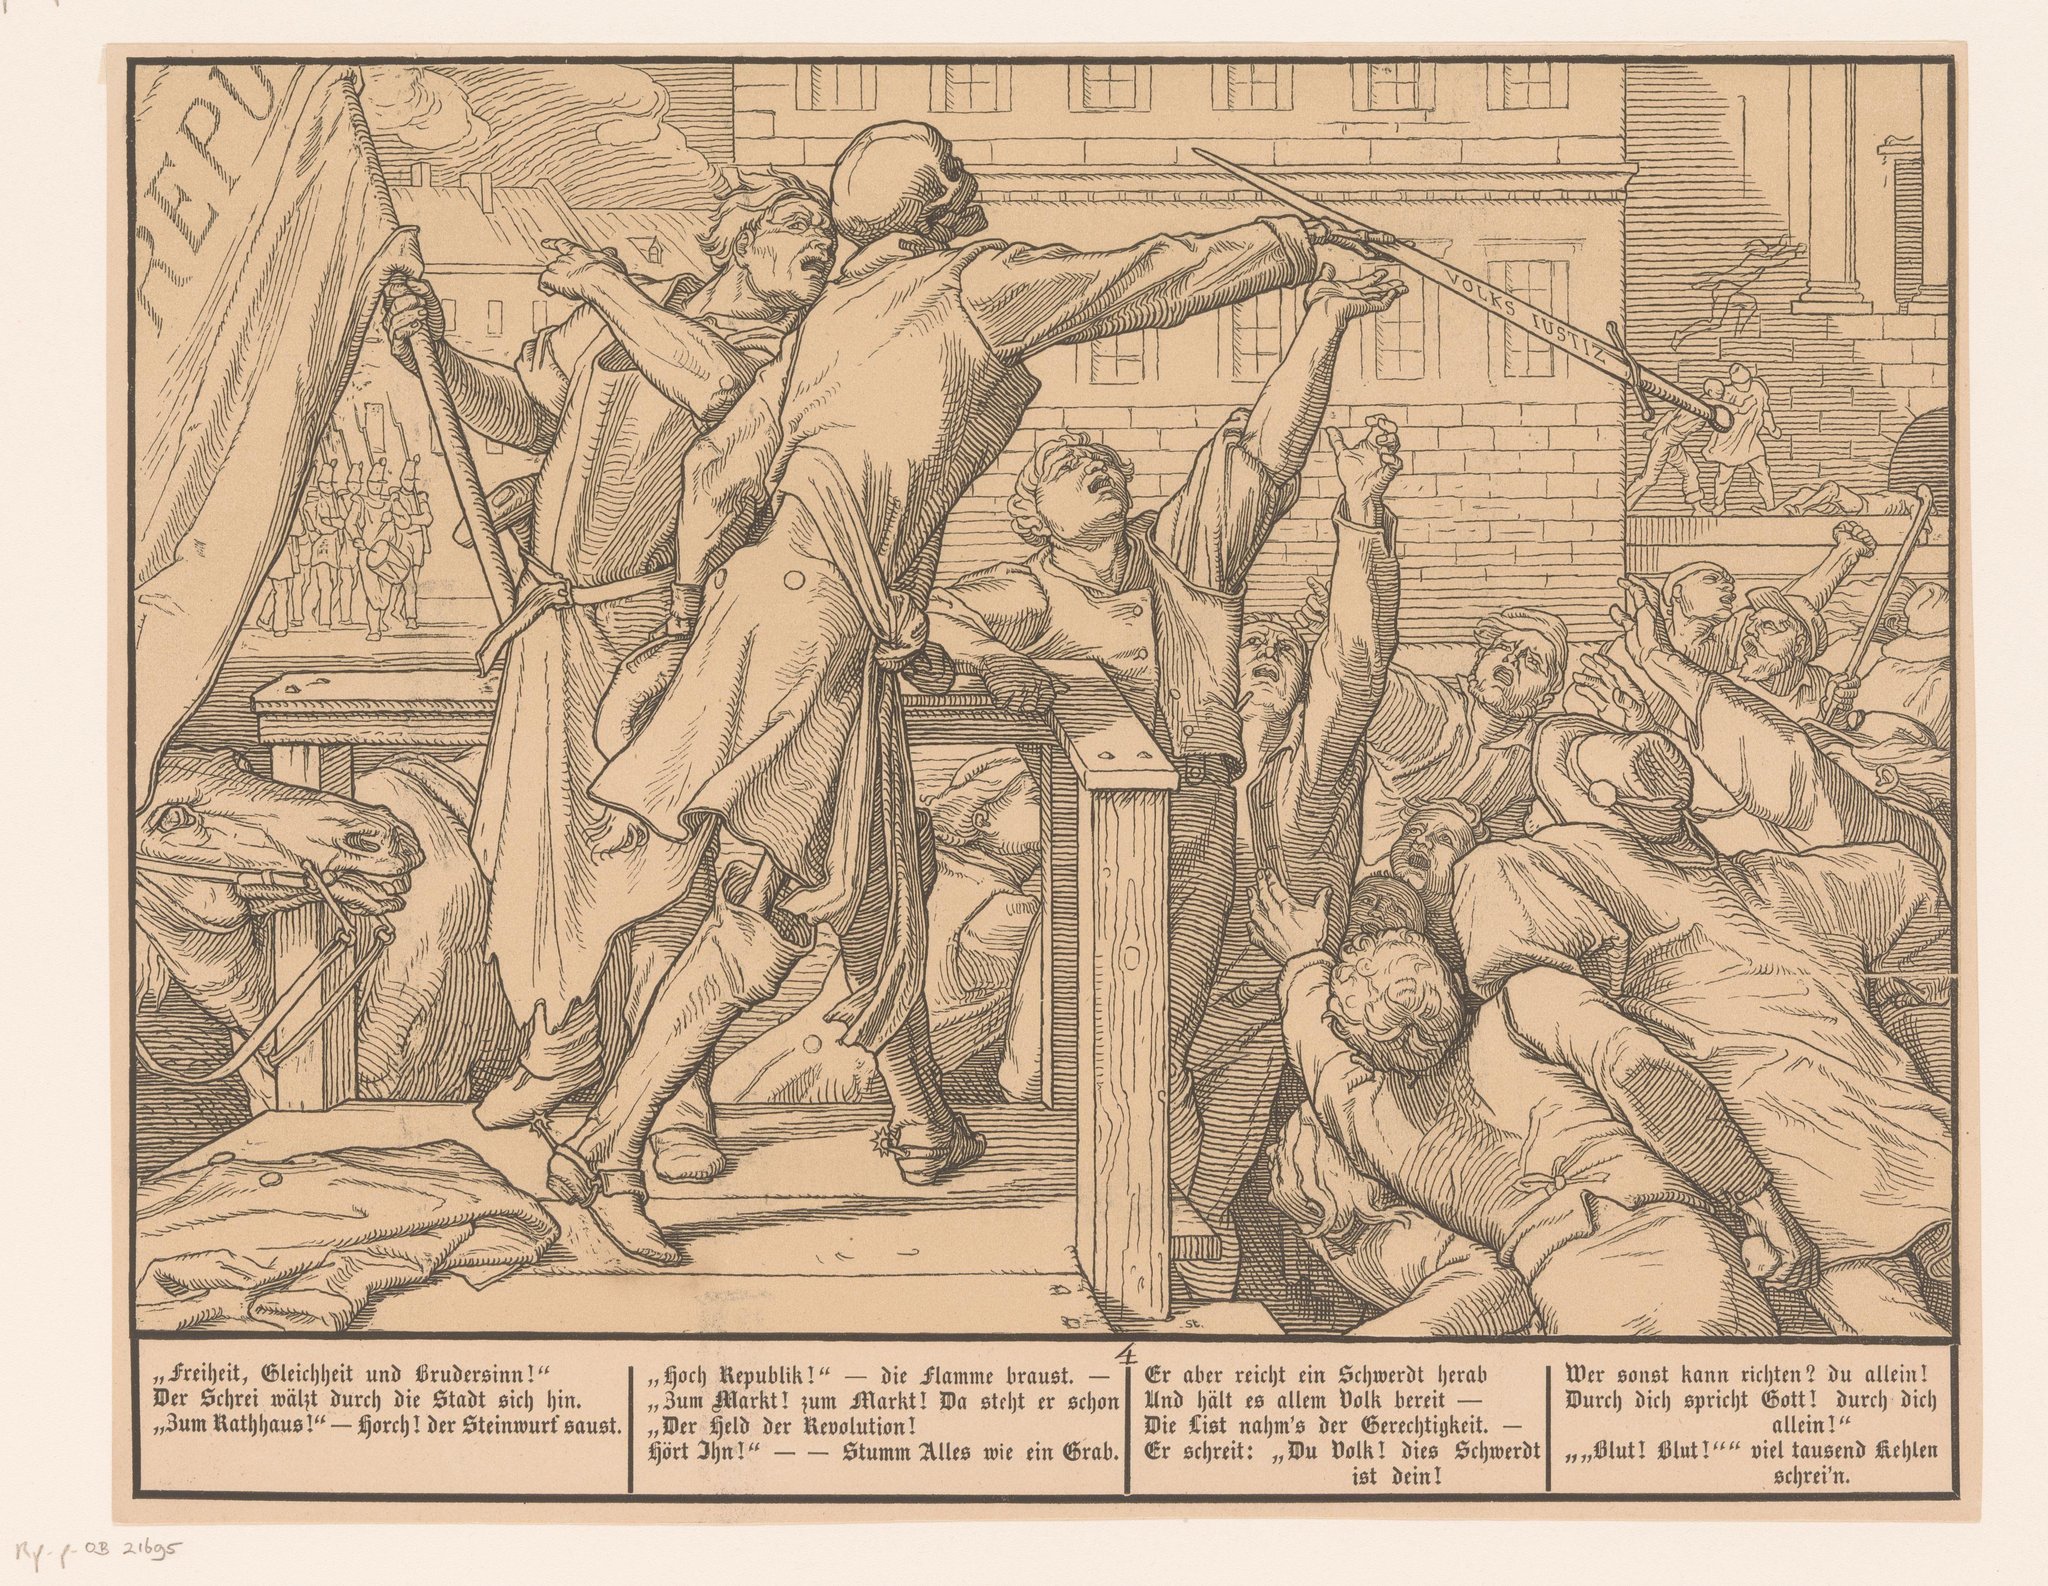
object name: print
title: Der Tod als Volksredner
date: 1848-1849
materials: paper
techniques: woodcut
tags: dance of death; death together with one or more human beings, revolution, revolt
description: Allegorie op de revolutie in de Duitse landen van 1848: "Ein Totentanz aus dem Jahre 1848", Volksuitgave van Augustus.